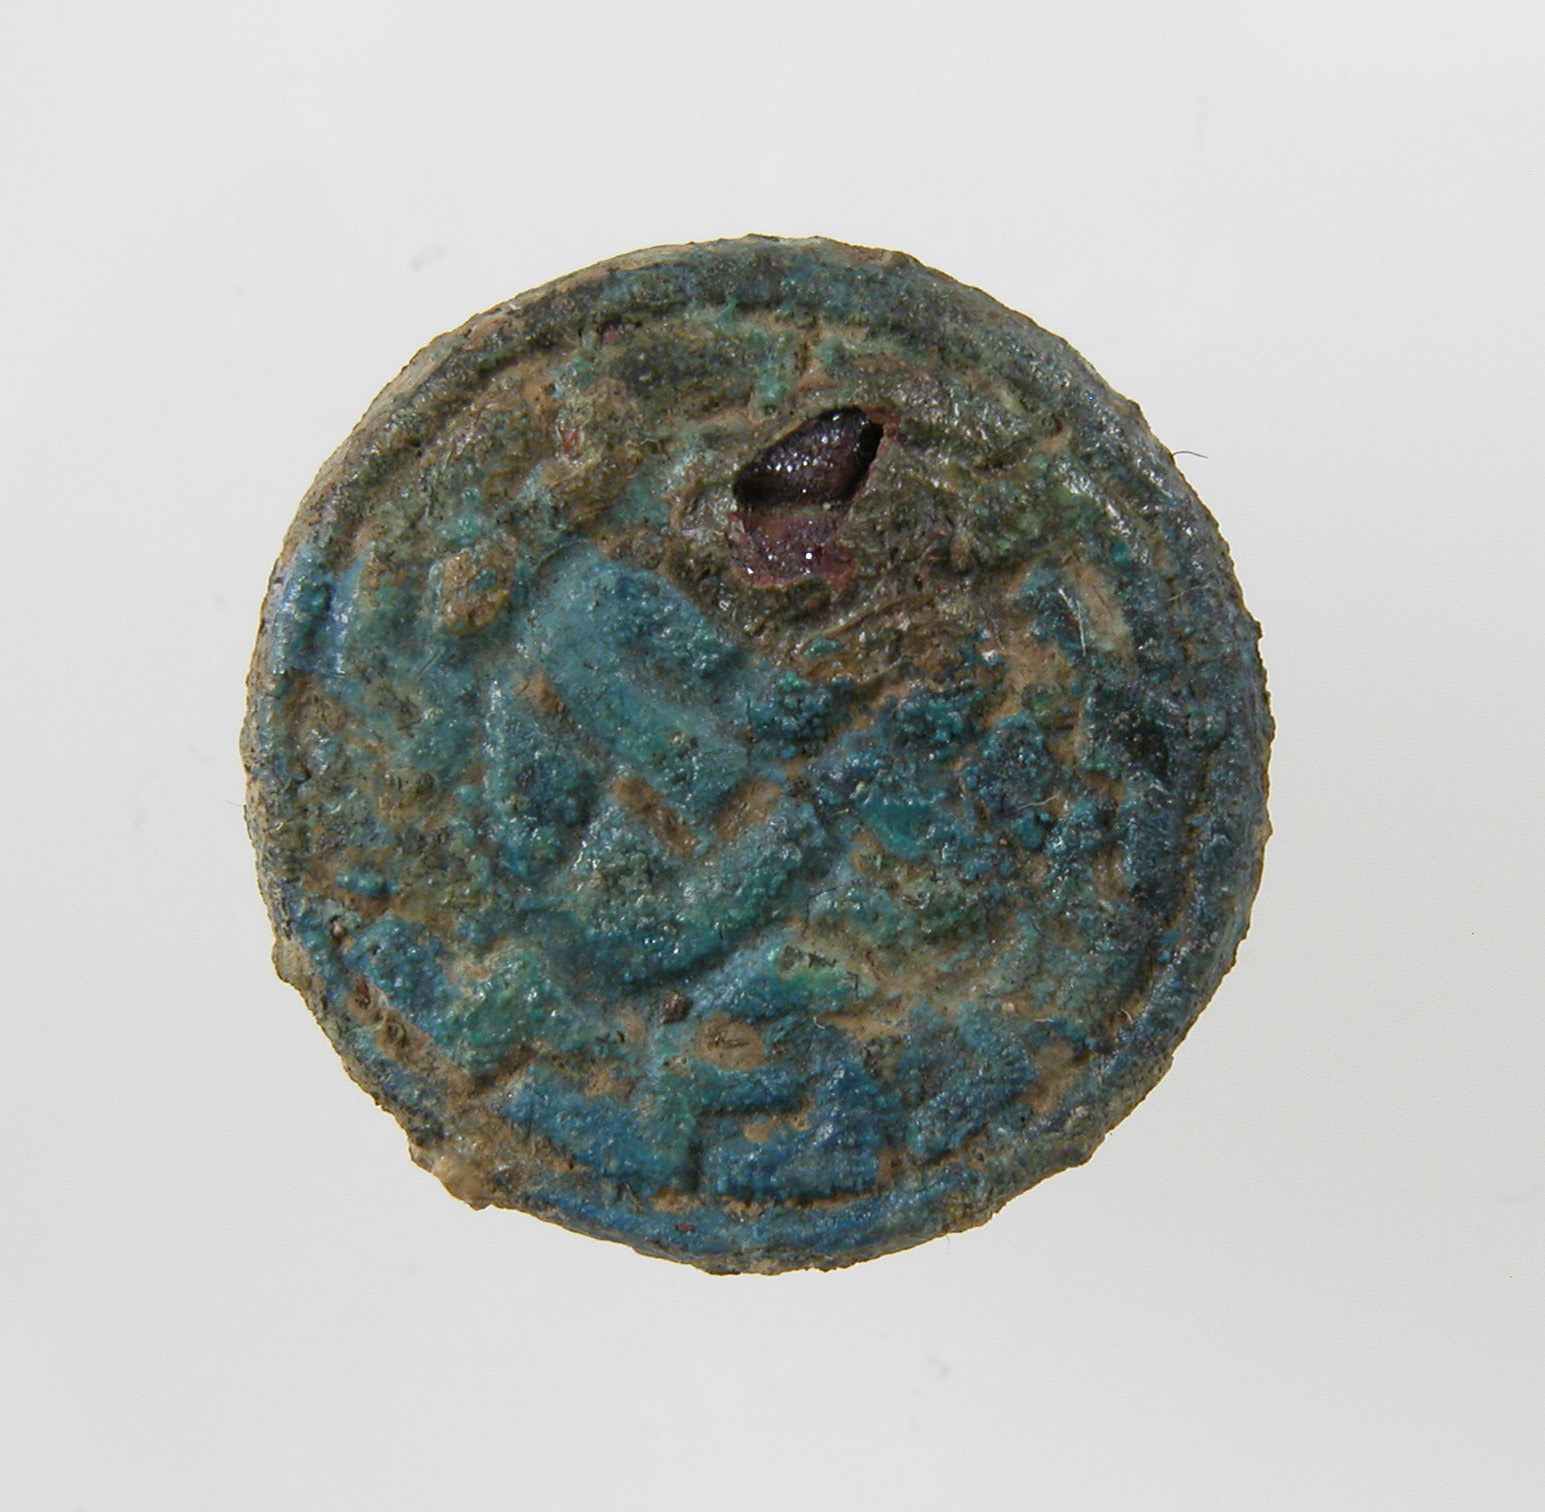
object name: stud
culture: frankish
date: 601-650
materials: copper alloy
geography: germany